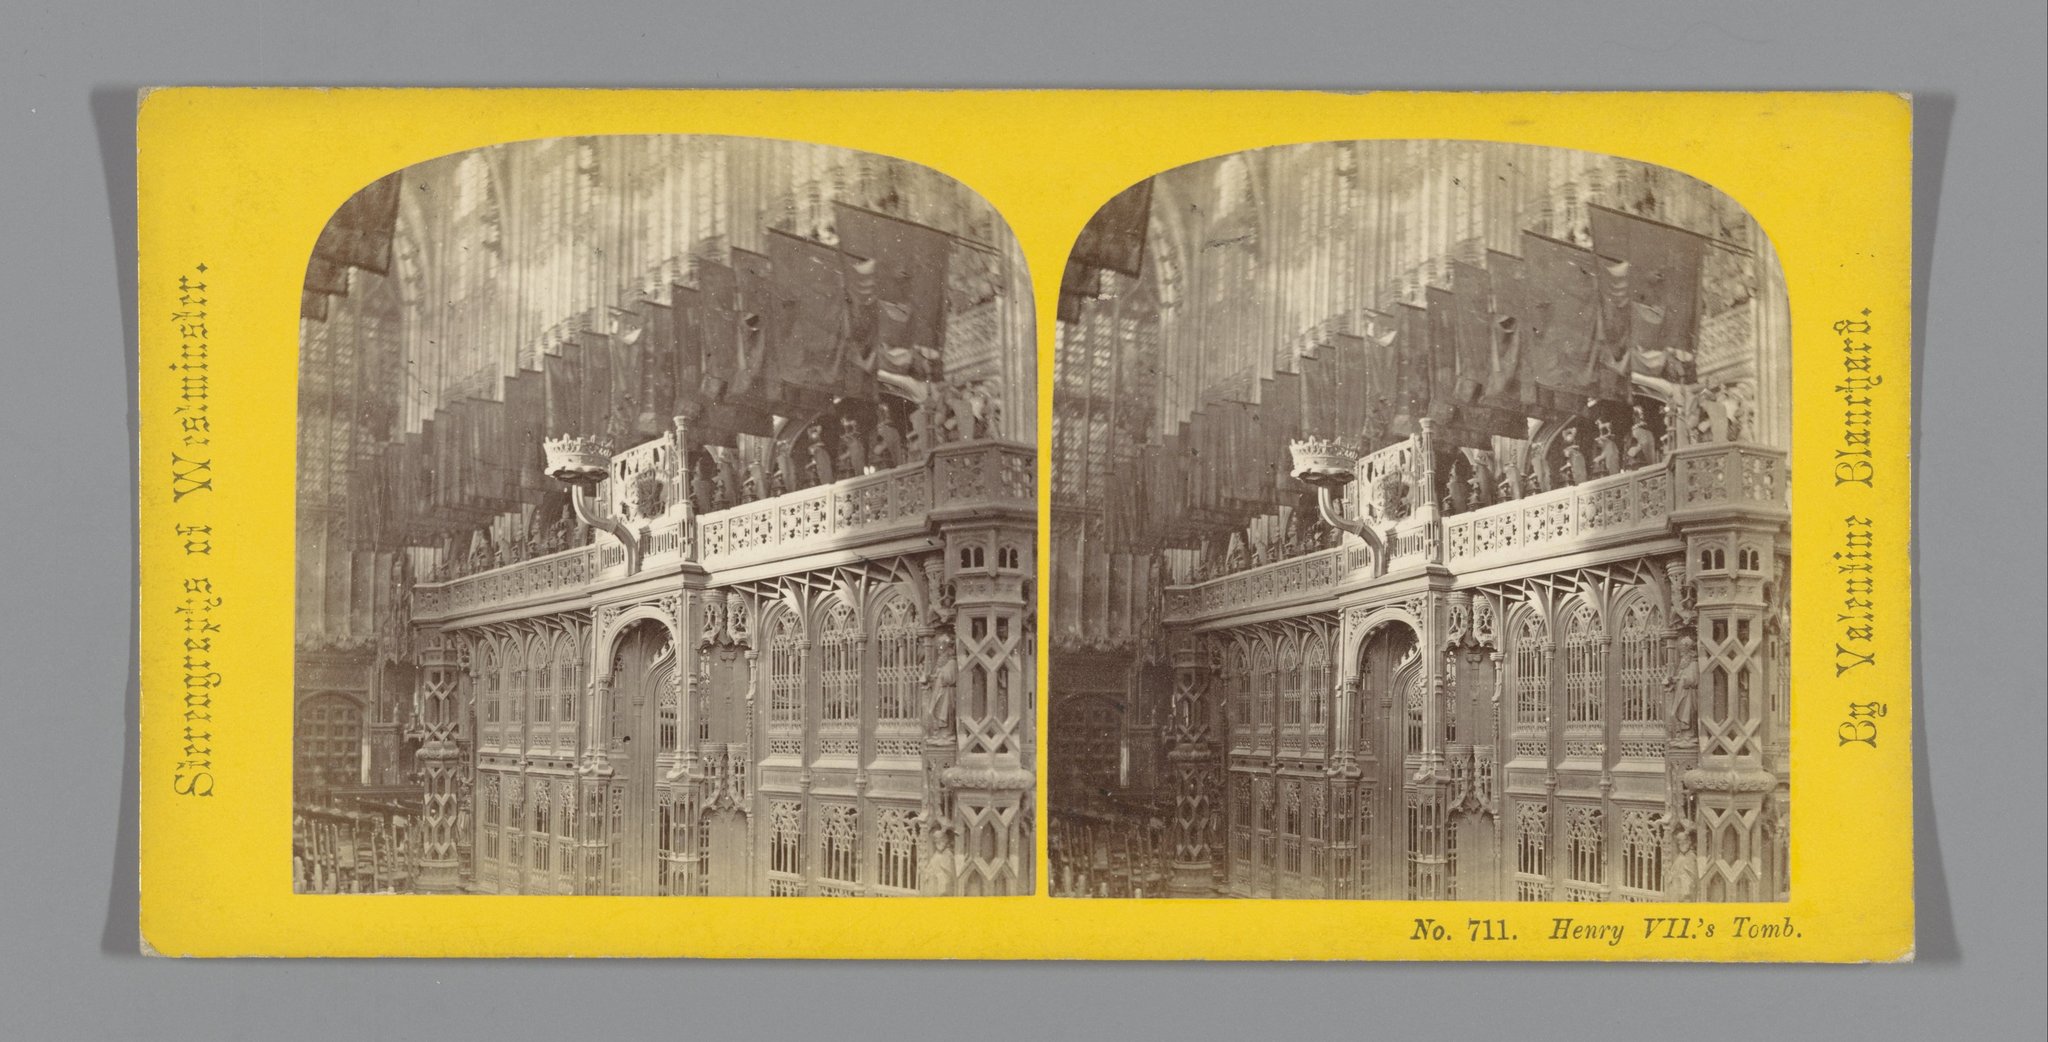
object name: stereograph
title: Henry VII's Tomb.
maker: valentine blanchard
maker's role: fotograaf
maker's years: 1831-1901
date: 1850-1880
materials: cardboard, photographic support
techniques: albumen print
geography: westminster abbey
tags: grave, tomb, interior of church, westminster abbey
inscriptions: inscription: ‘Stereographs of Westminster, By Valentine Blanchard.’, number: ‘No. 711.’